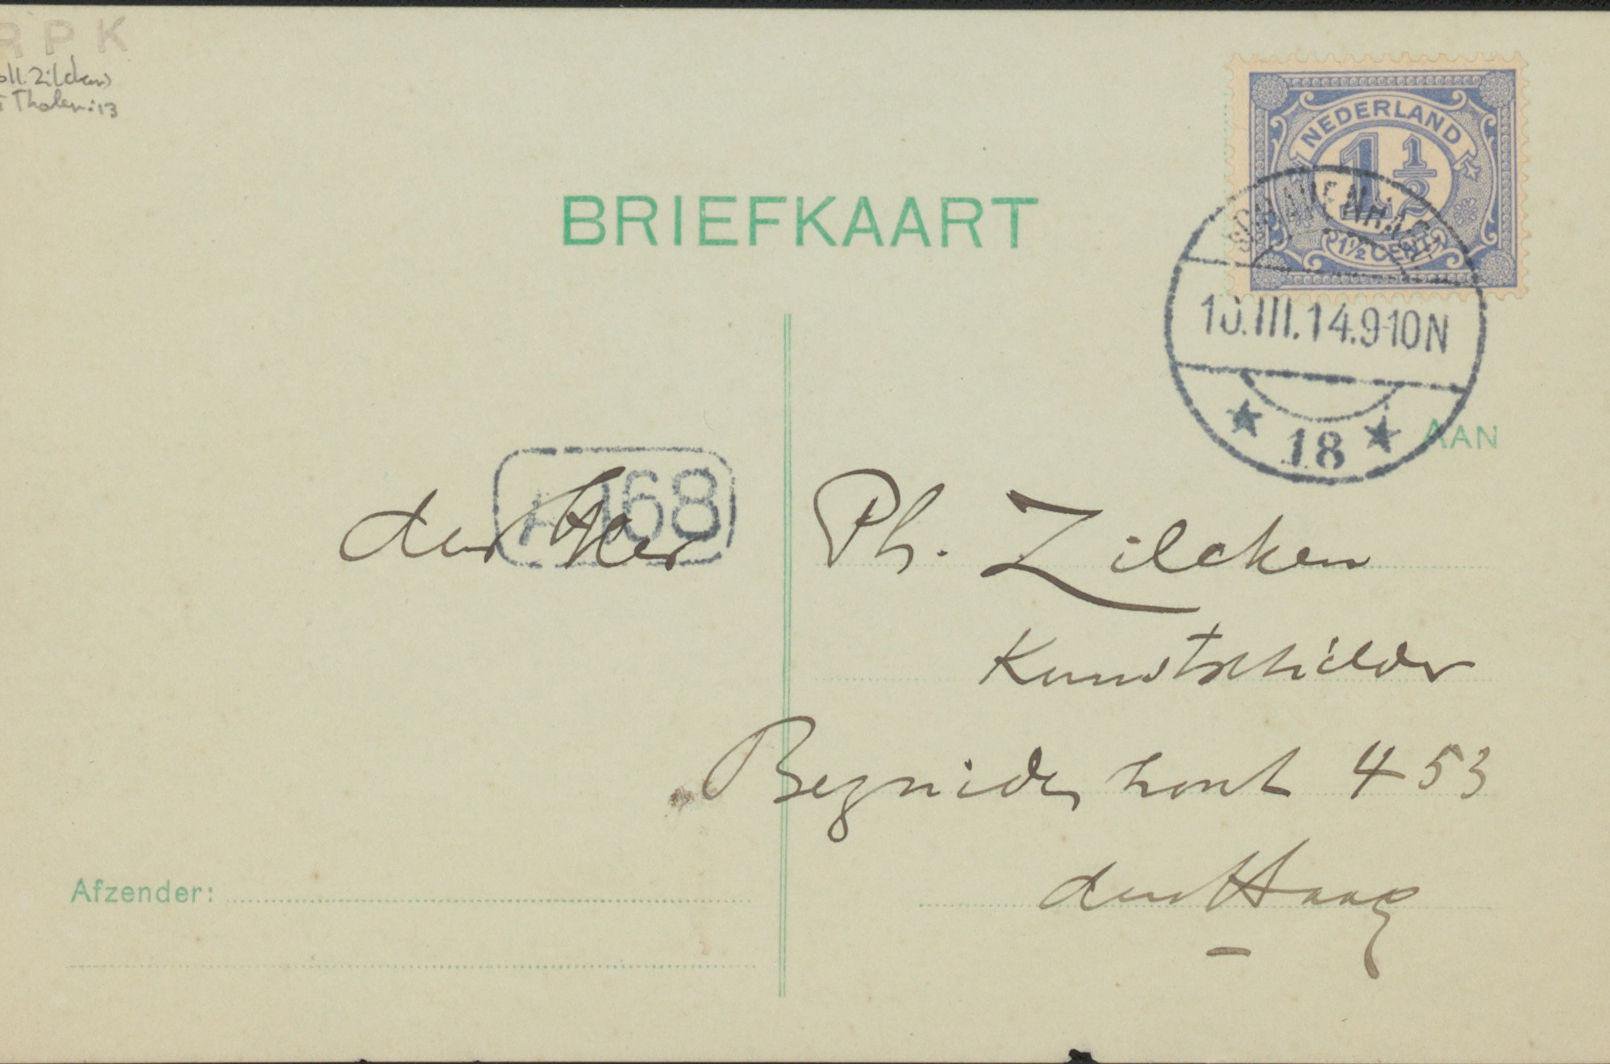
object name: postcard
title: Briefkaart aan Philip Zilcken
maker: willem bastiaan tholen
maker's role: draughtsman, painter, print maker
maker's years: 1860-1931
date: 1914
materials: cardboard, ink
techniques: pen, writing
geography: the hague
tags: philip zilcken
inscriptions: collector's mark: ‘RPK’